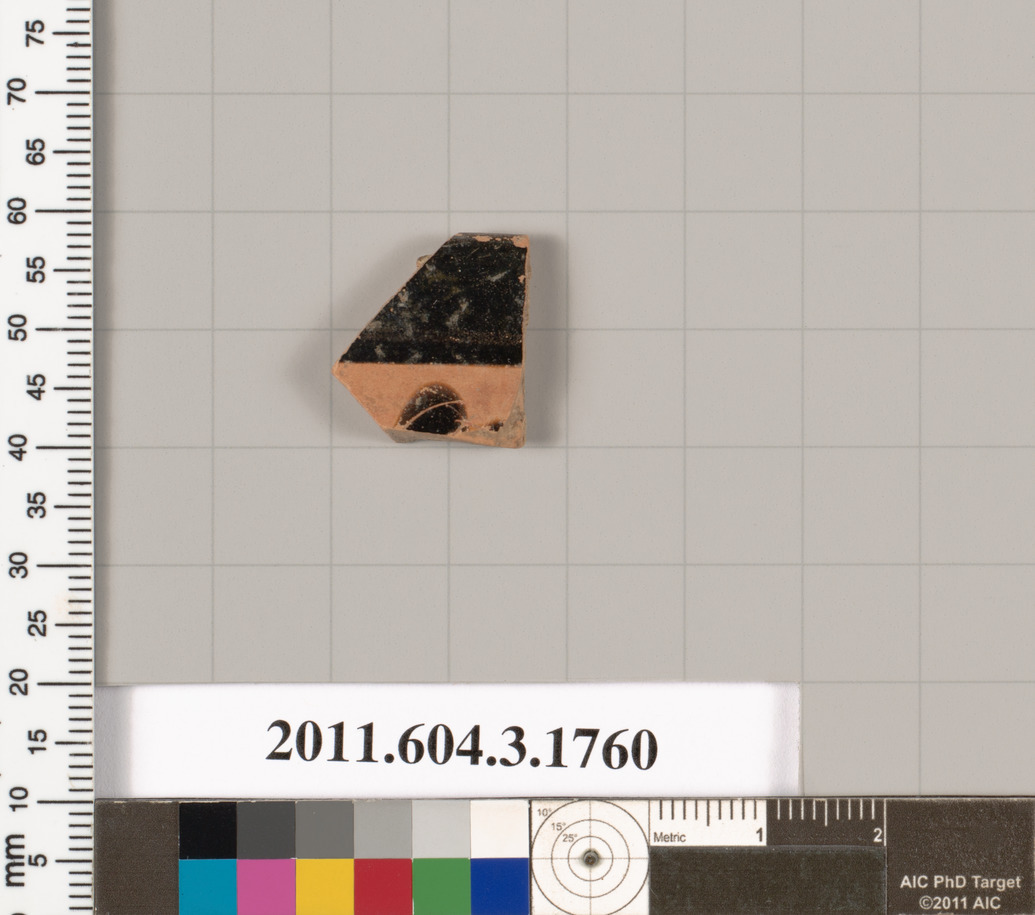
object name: kylix fragment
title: Terracotta rim fragment of a kylix: Band cup (drinking cup)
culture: greek, attic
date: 550-501 BCE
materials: terracotta